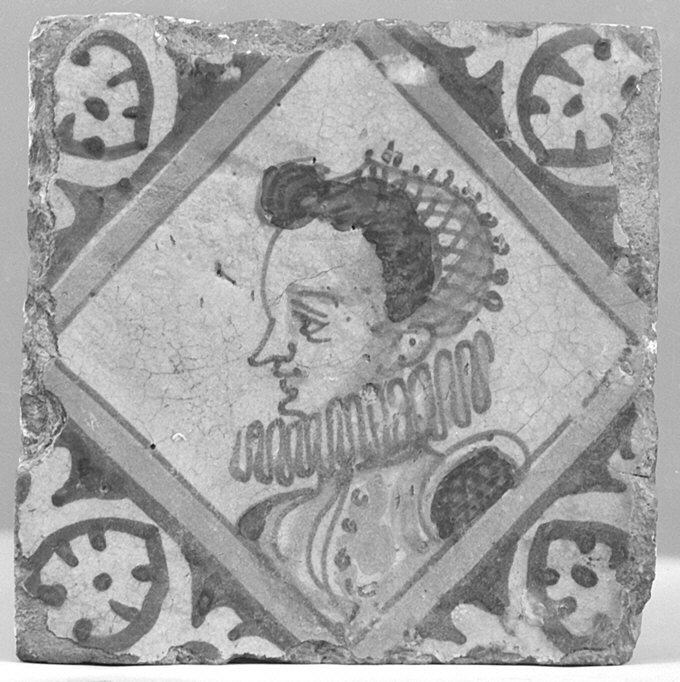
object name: tile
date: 1600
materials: earthenware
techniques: glazing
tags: portraits,women